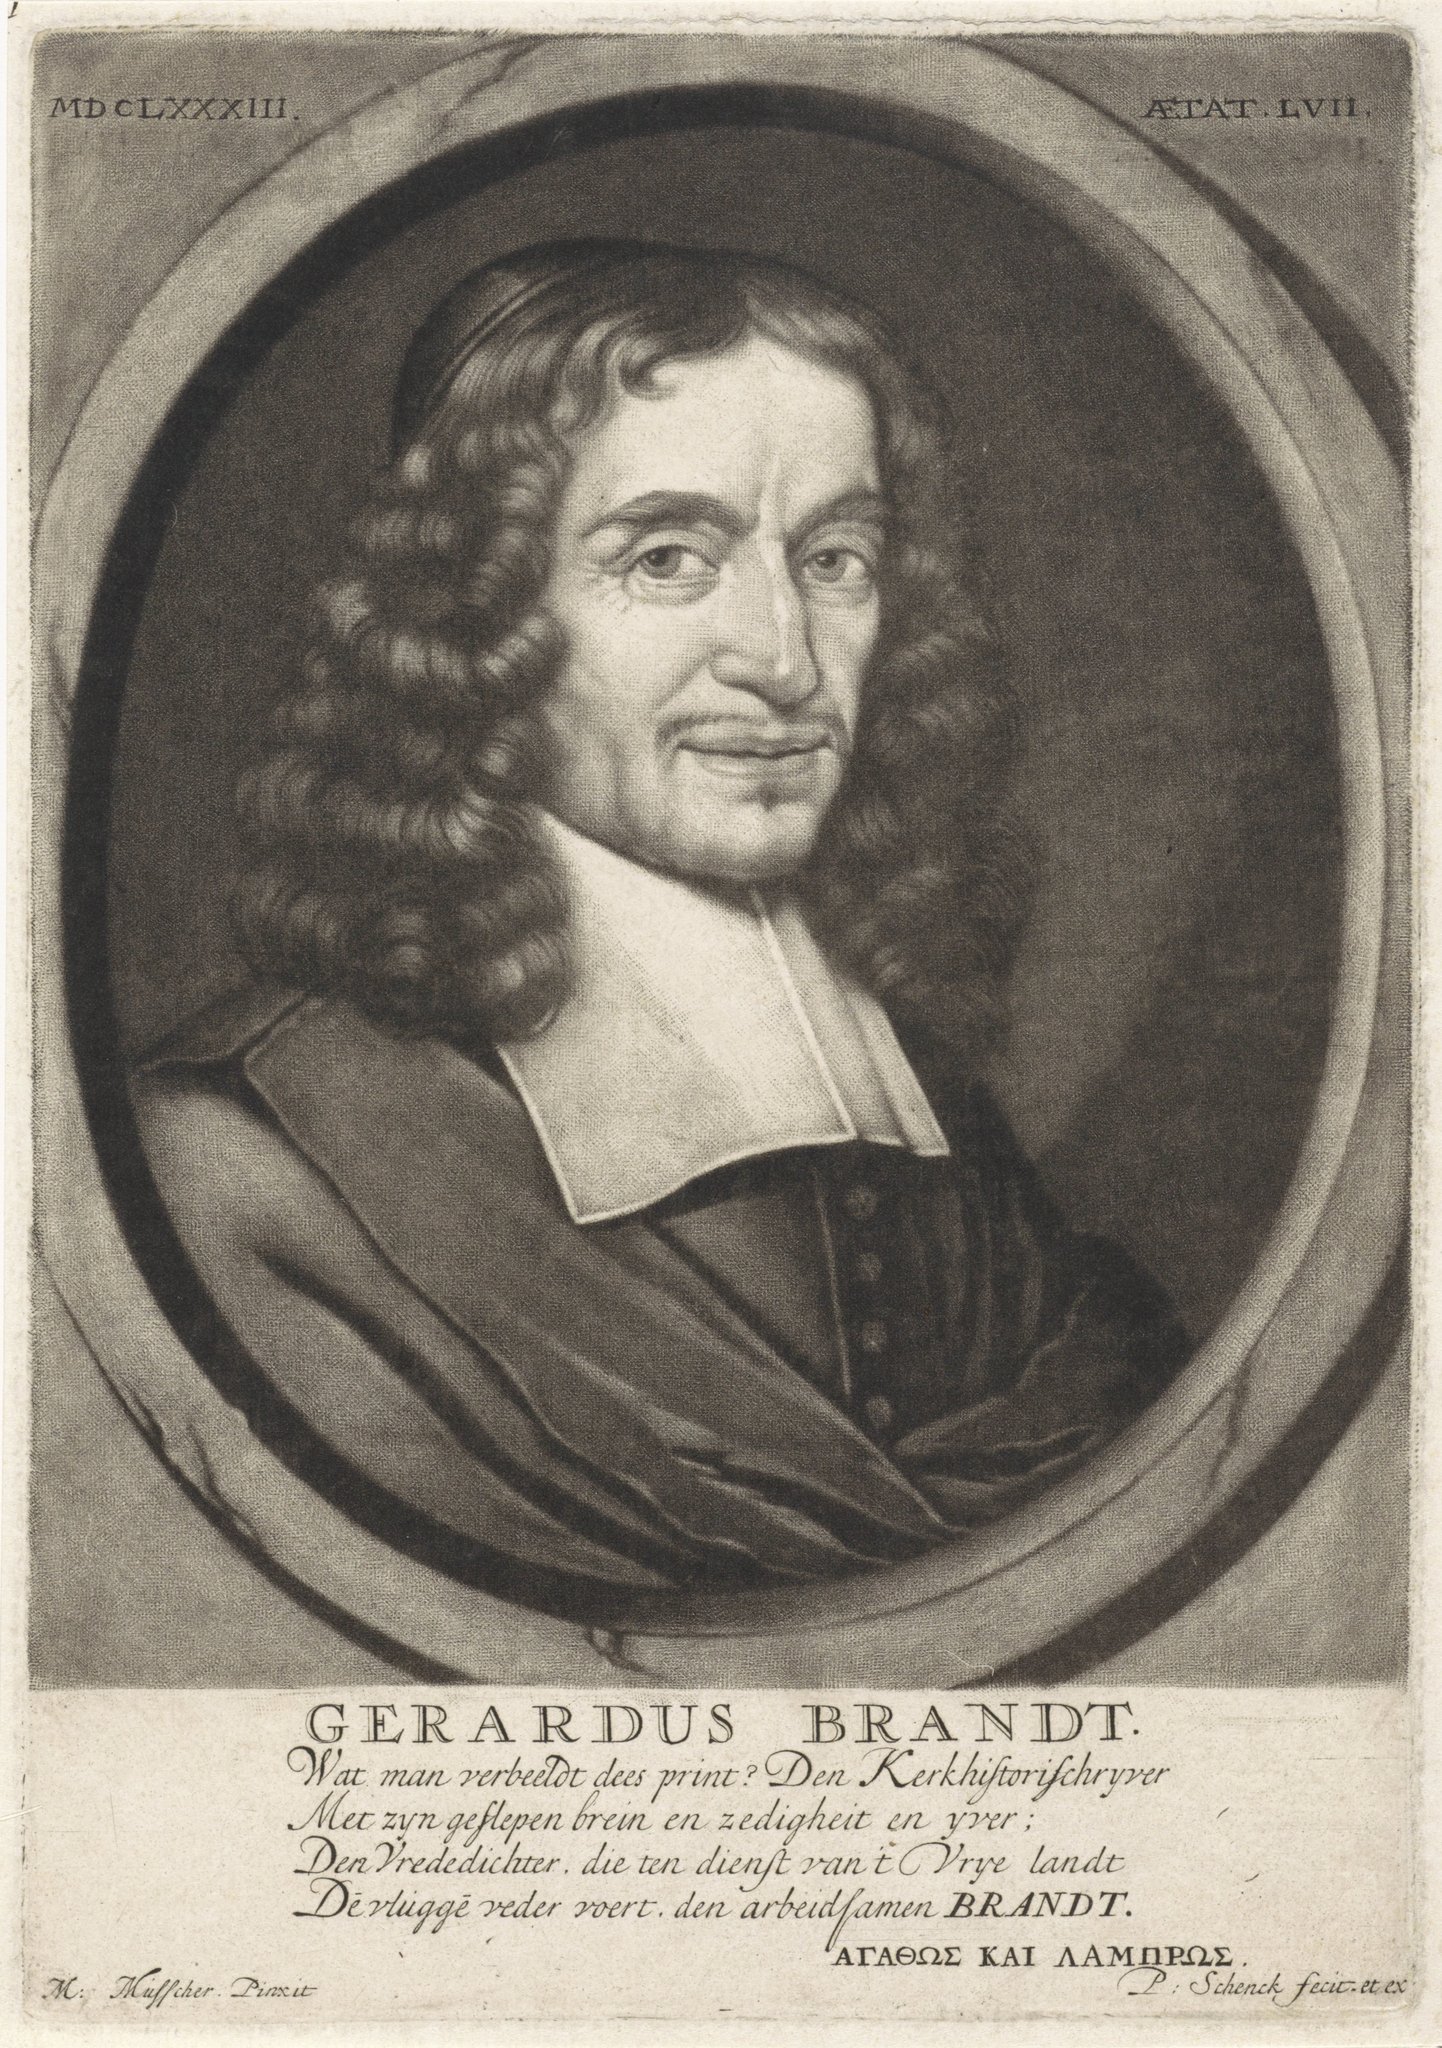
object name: print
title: Portret van Geeraert Brandt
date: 1683-1713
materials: paper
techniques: engraving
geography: amsterdam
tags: geeraert brandt (i)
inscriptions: collector's mark: Lugt 2228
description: Geeraert Brandt, historicus, dichter en toneelschrijver in Amsterdam op 57-jarige leeftijd.